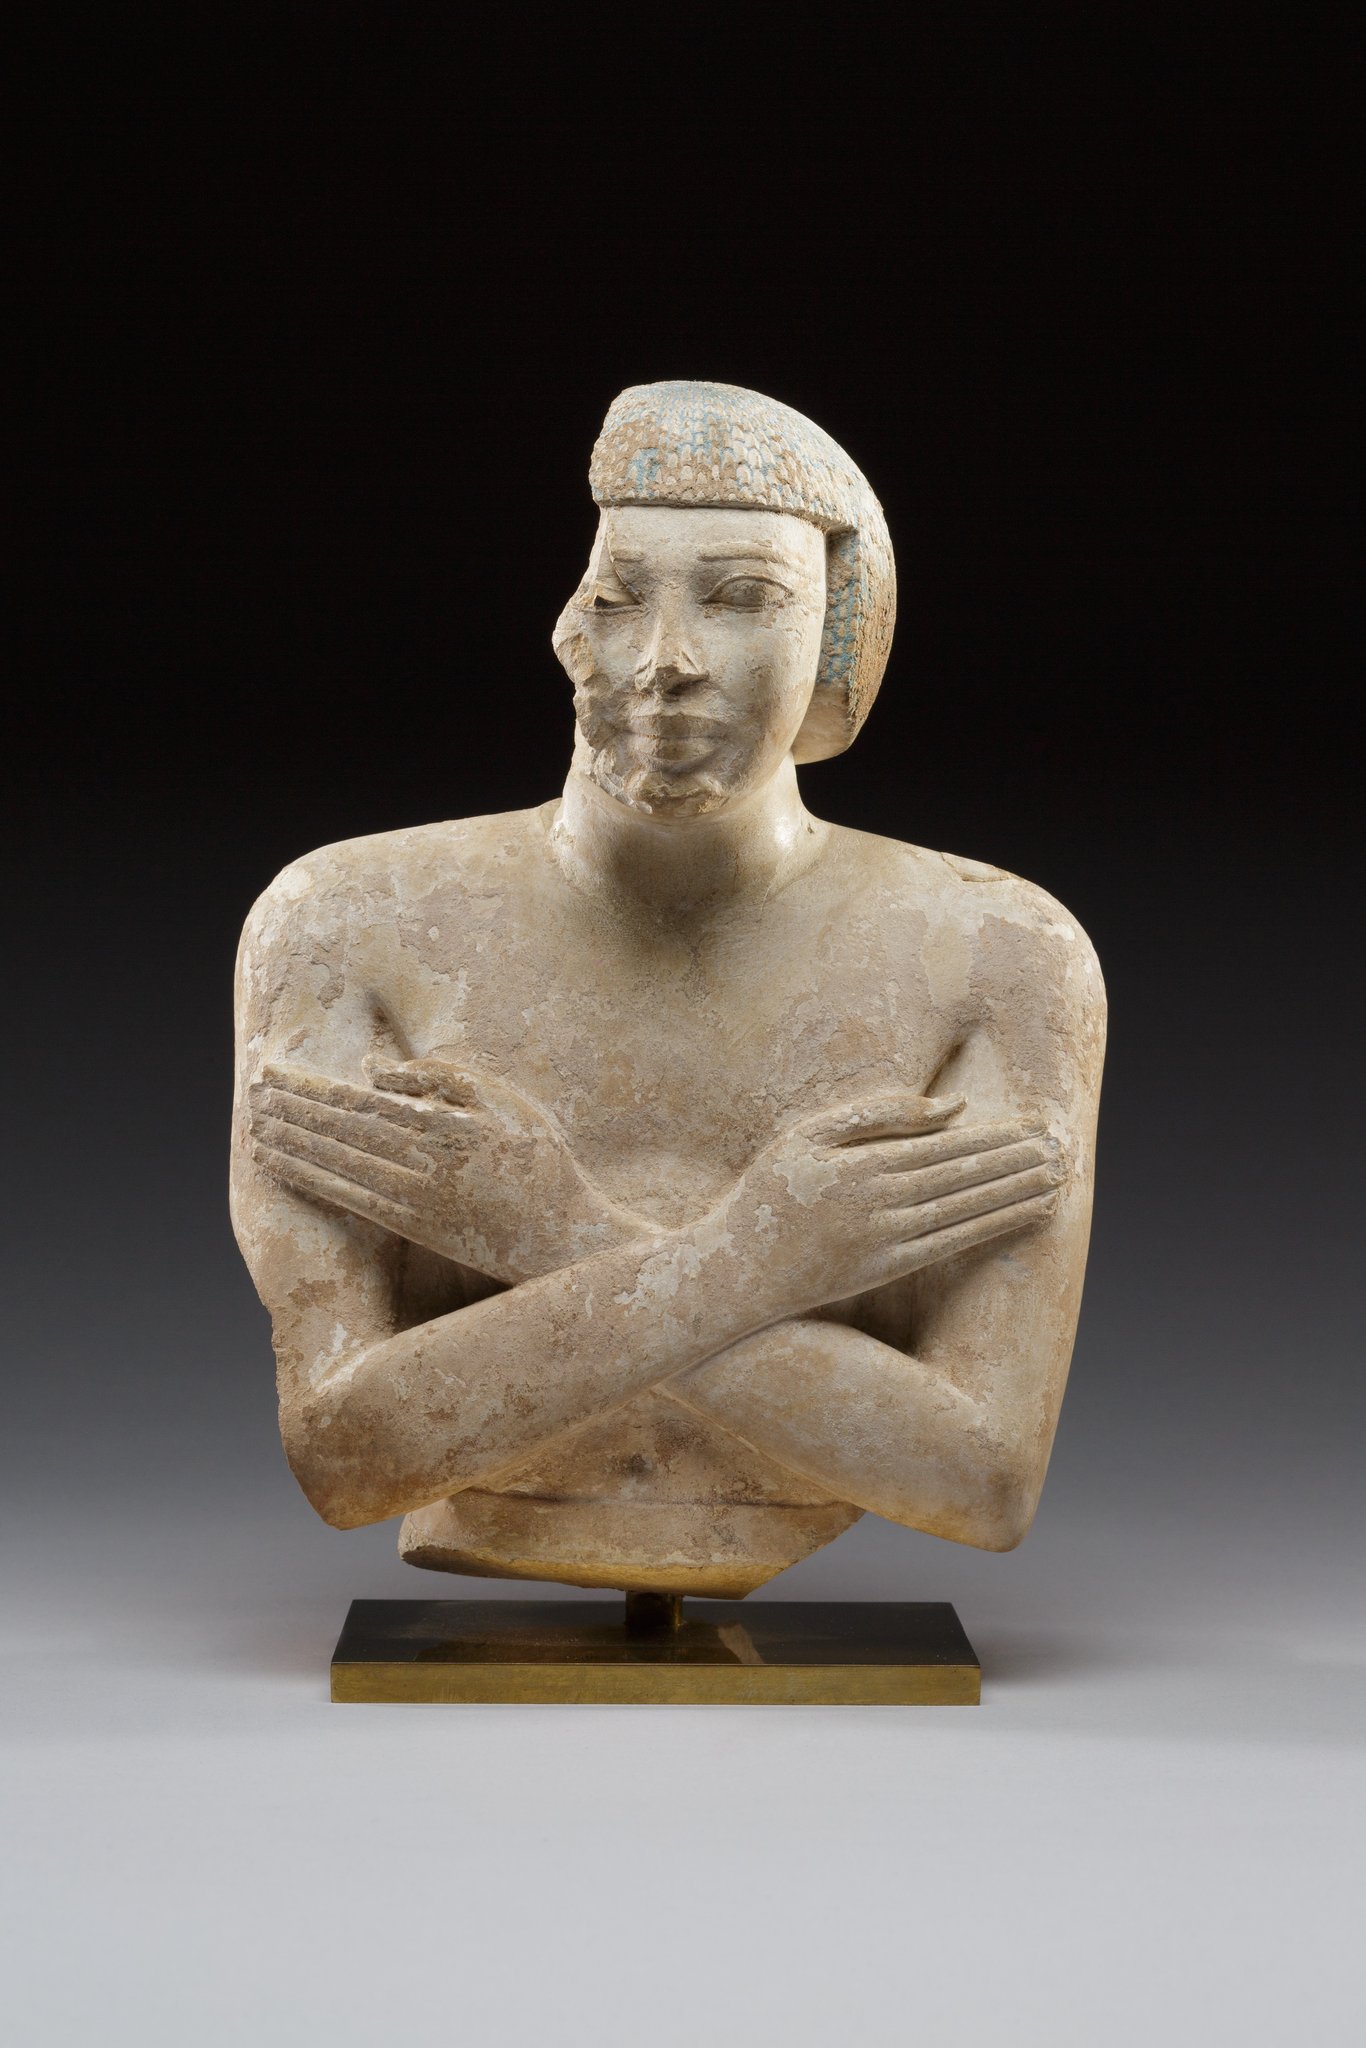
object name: bust, iqer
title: Upper part of a statue of Iqer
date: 2000-1917 BCE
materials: limestone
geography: egypt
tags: men